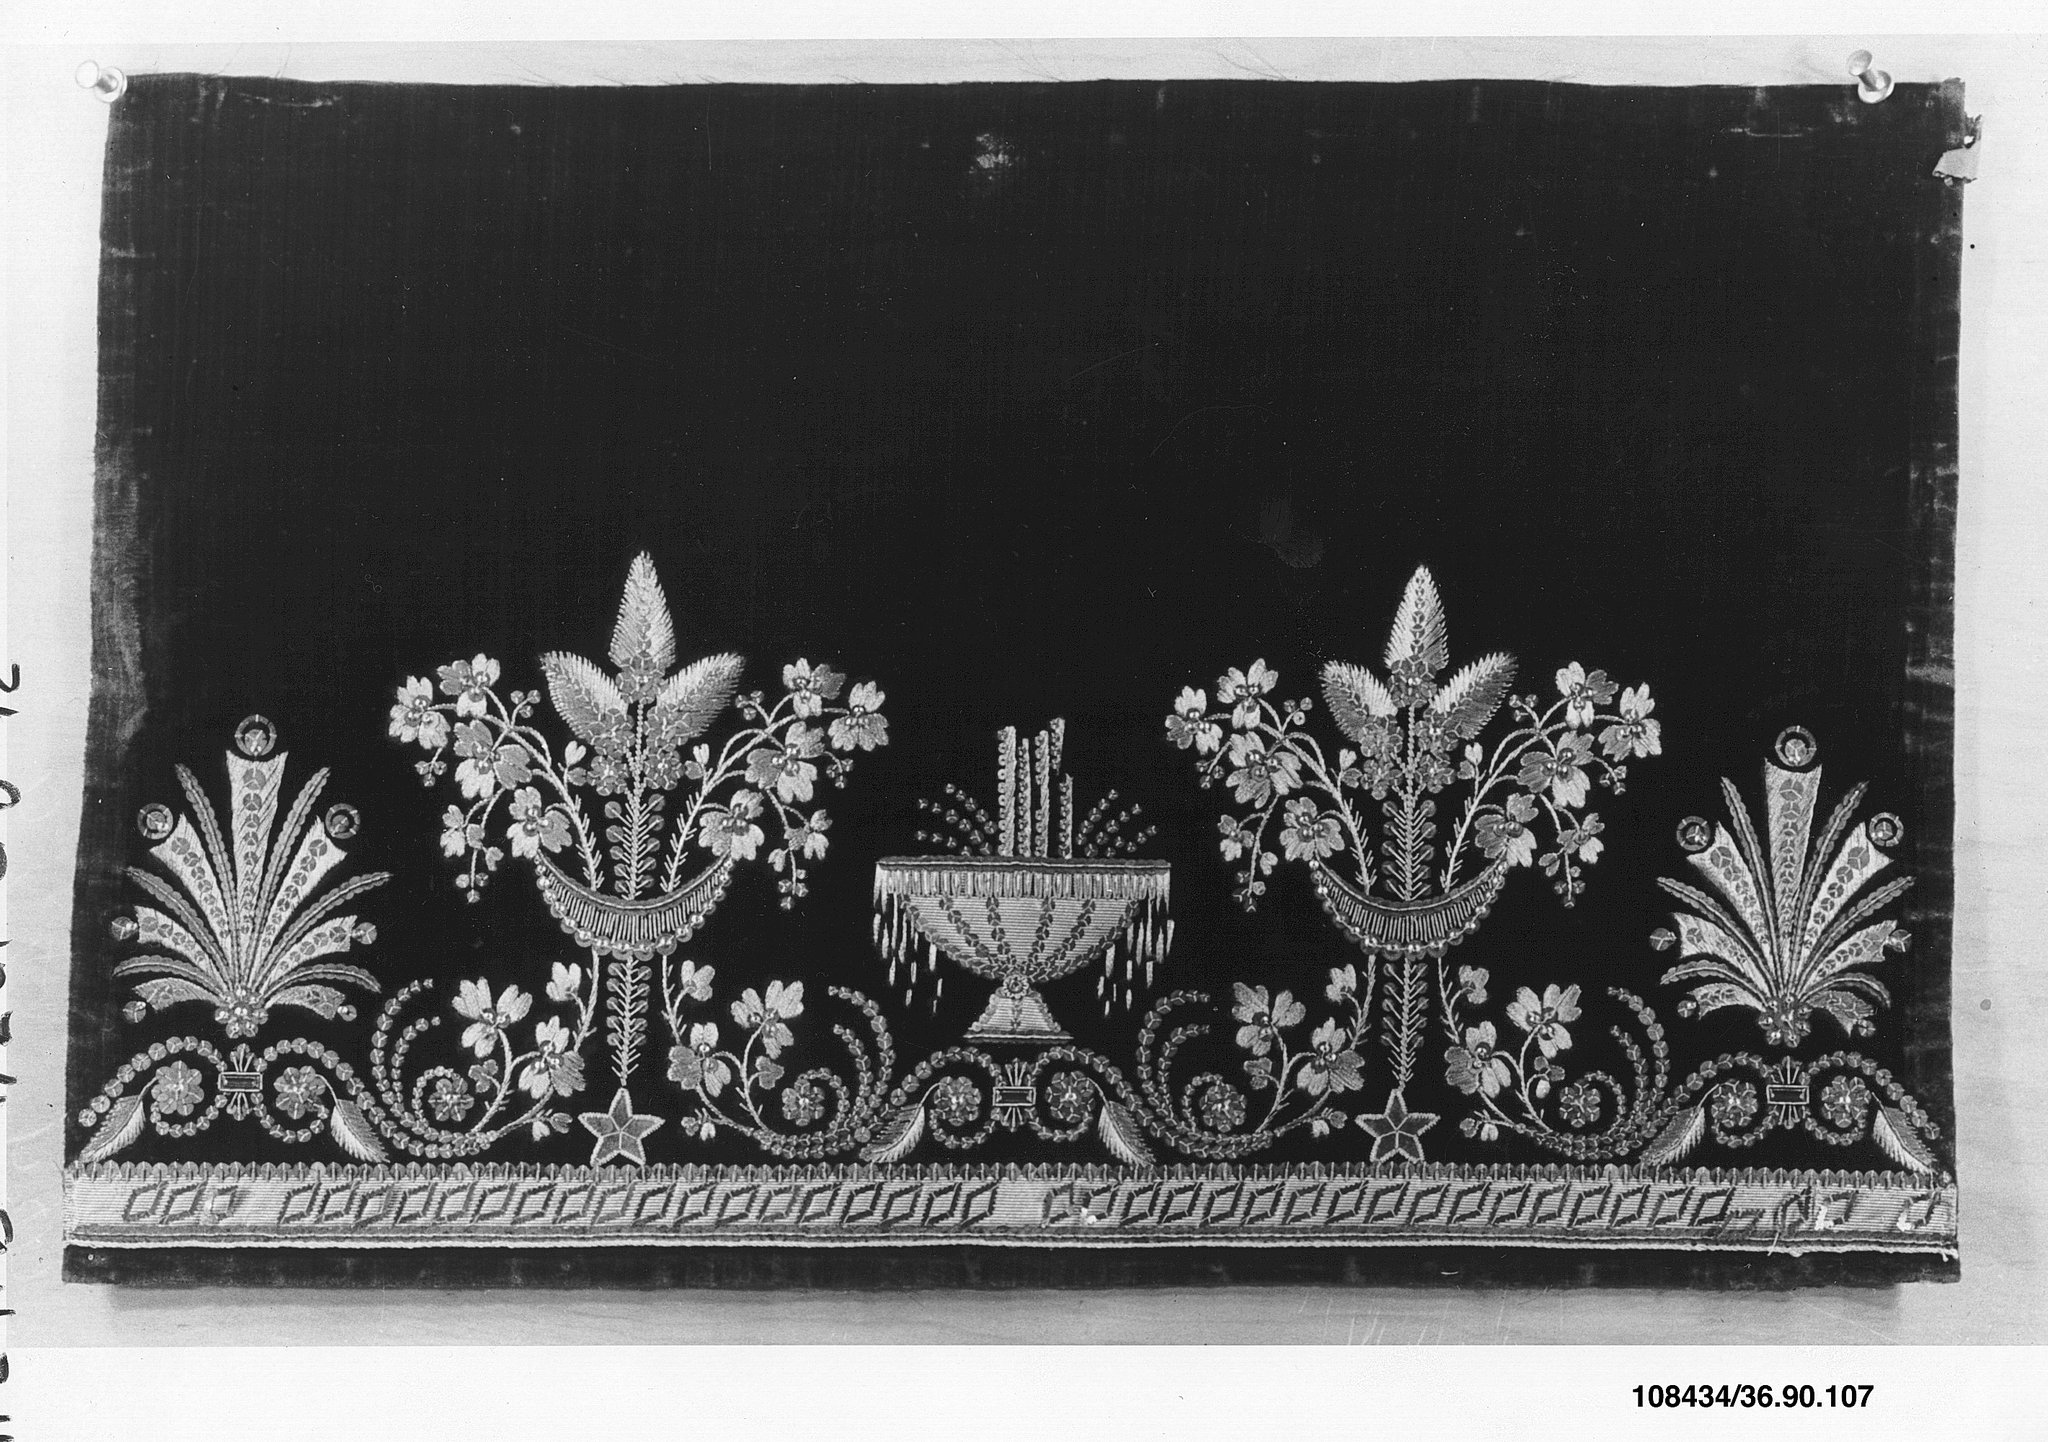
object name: border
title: Dress border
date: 1801-1833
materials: metal thread, silk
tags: flowers